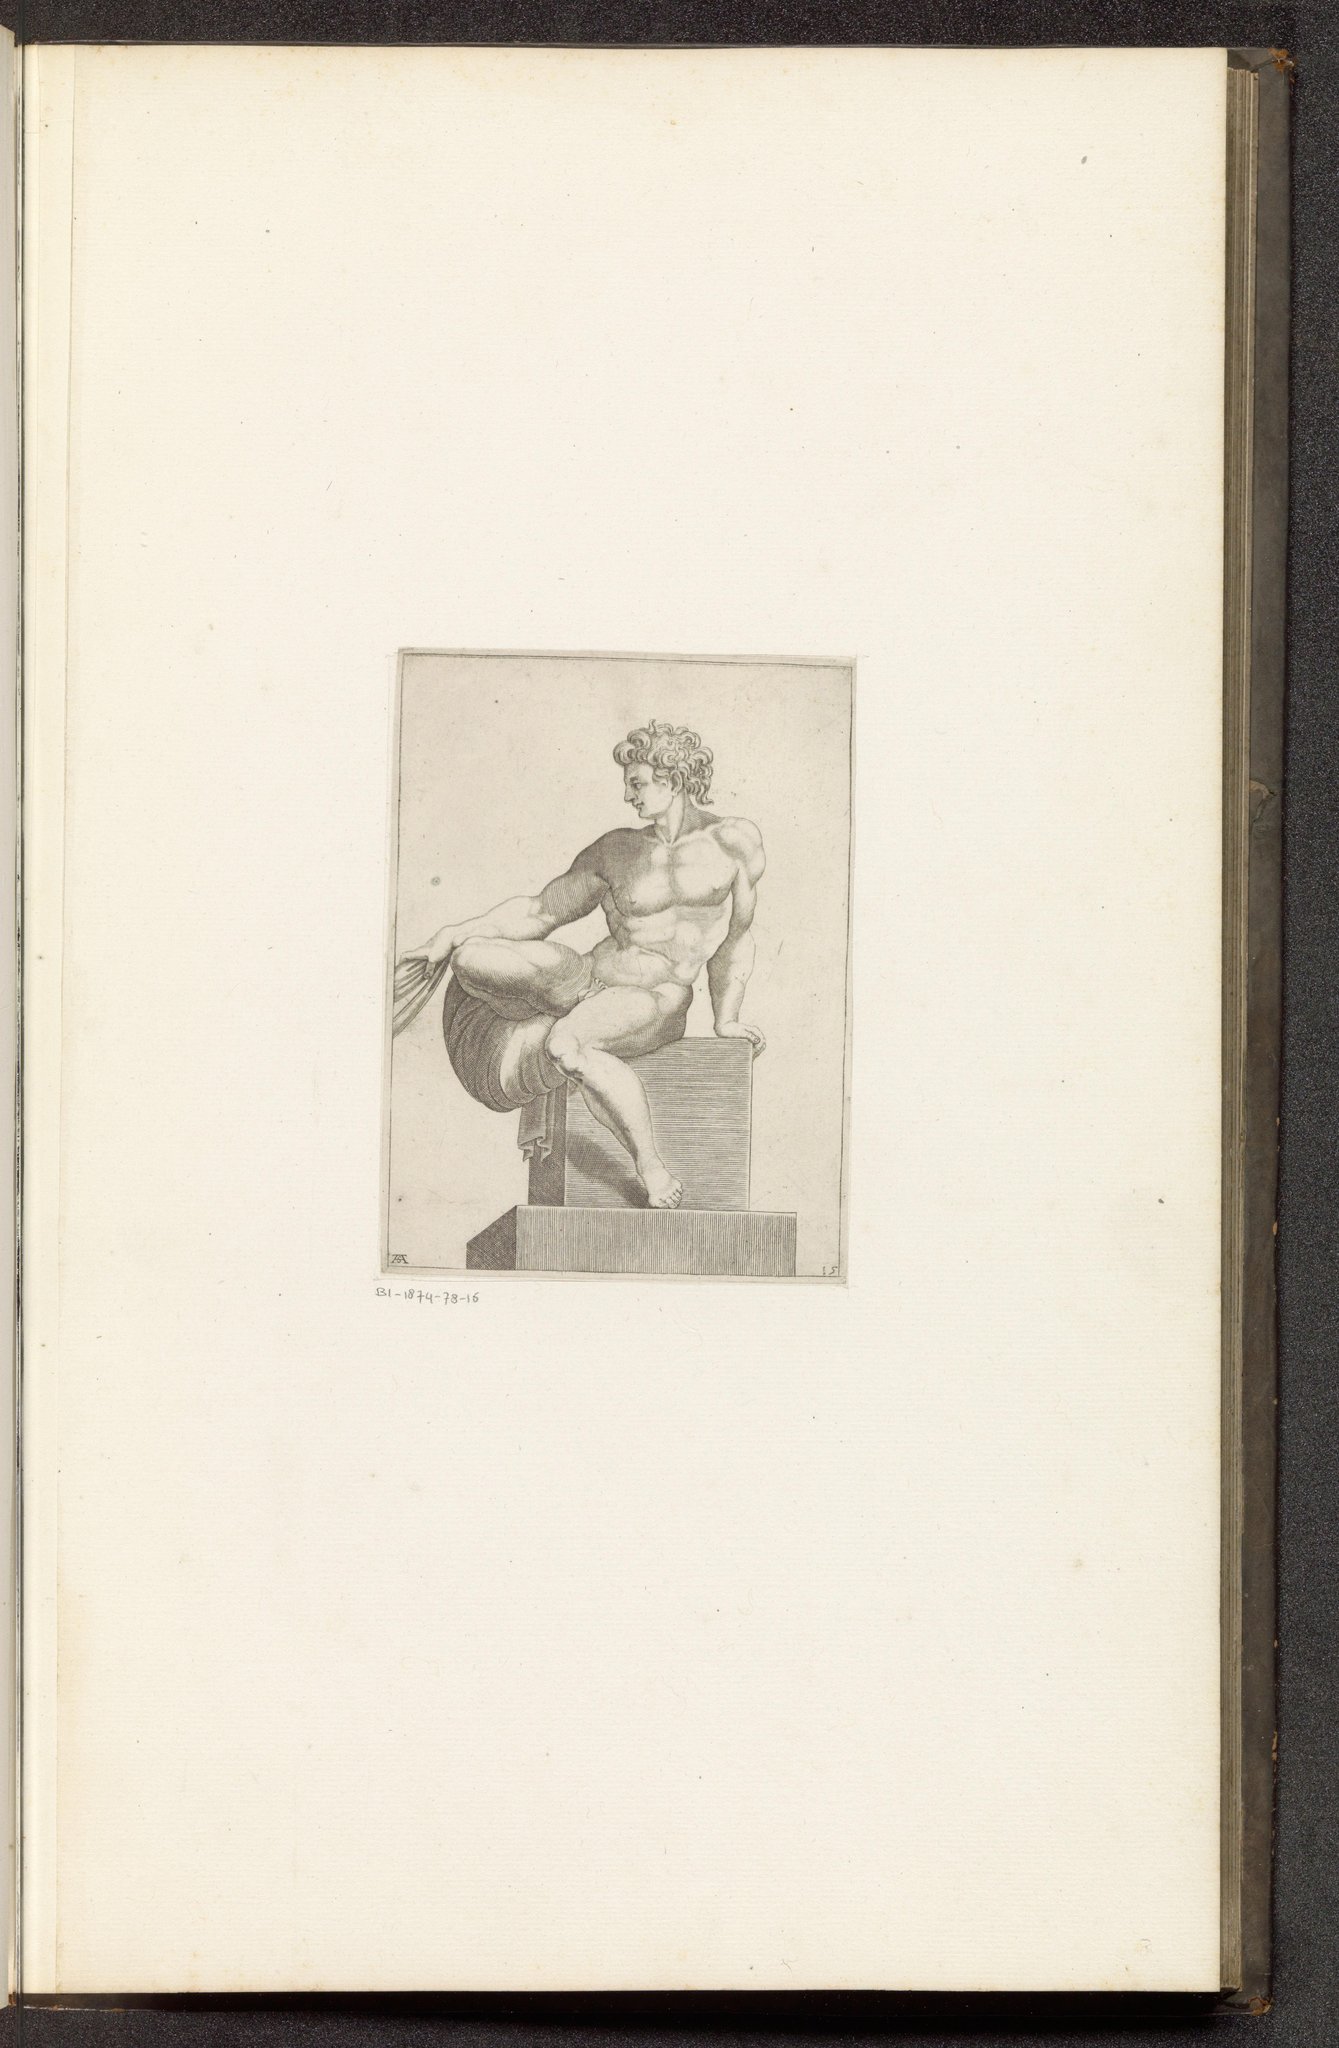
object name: album leaf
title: Zittend naakt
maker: adamo scultori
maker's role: painter, print maker, sculptor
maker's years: 1530-1585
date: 1585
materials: paper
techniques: engraving, intaglio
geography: italy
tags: the (nude) human figure; 'corpo humano' (ripa)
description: Zittende naakte man, naar links gedraaid. Eén van de 'ignudi' (naakte mannen) van Michelangelo's plafondschildering. Genummerd rechtsonder: 15. De prent maakt deel uit van een album.